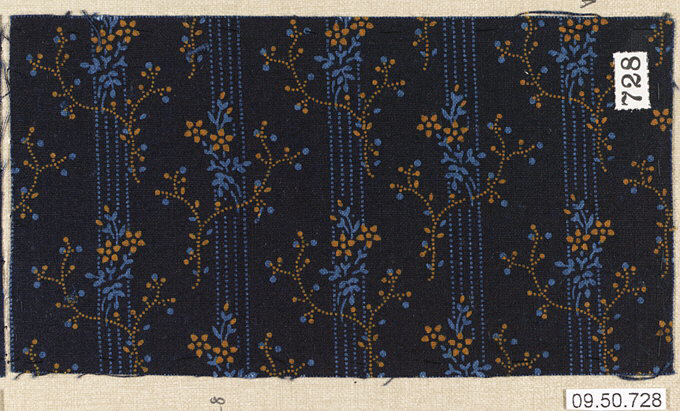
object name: piece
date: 1801-1900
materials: cotton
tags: flowers,leaves